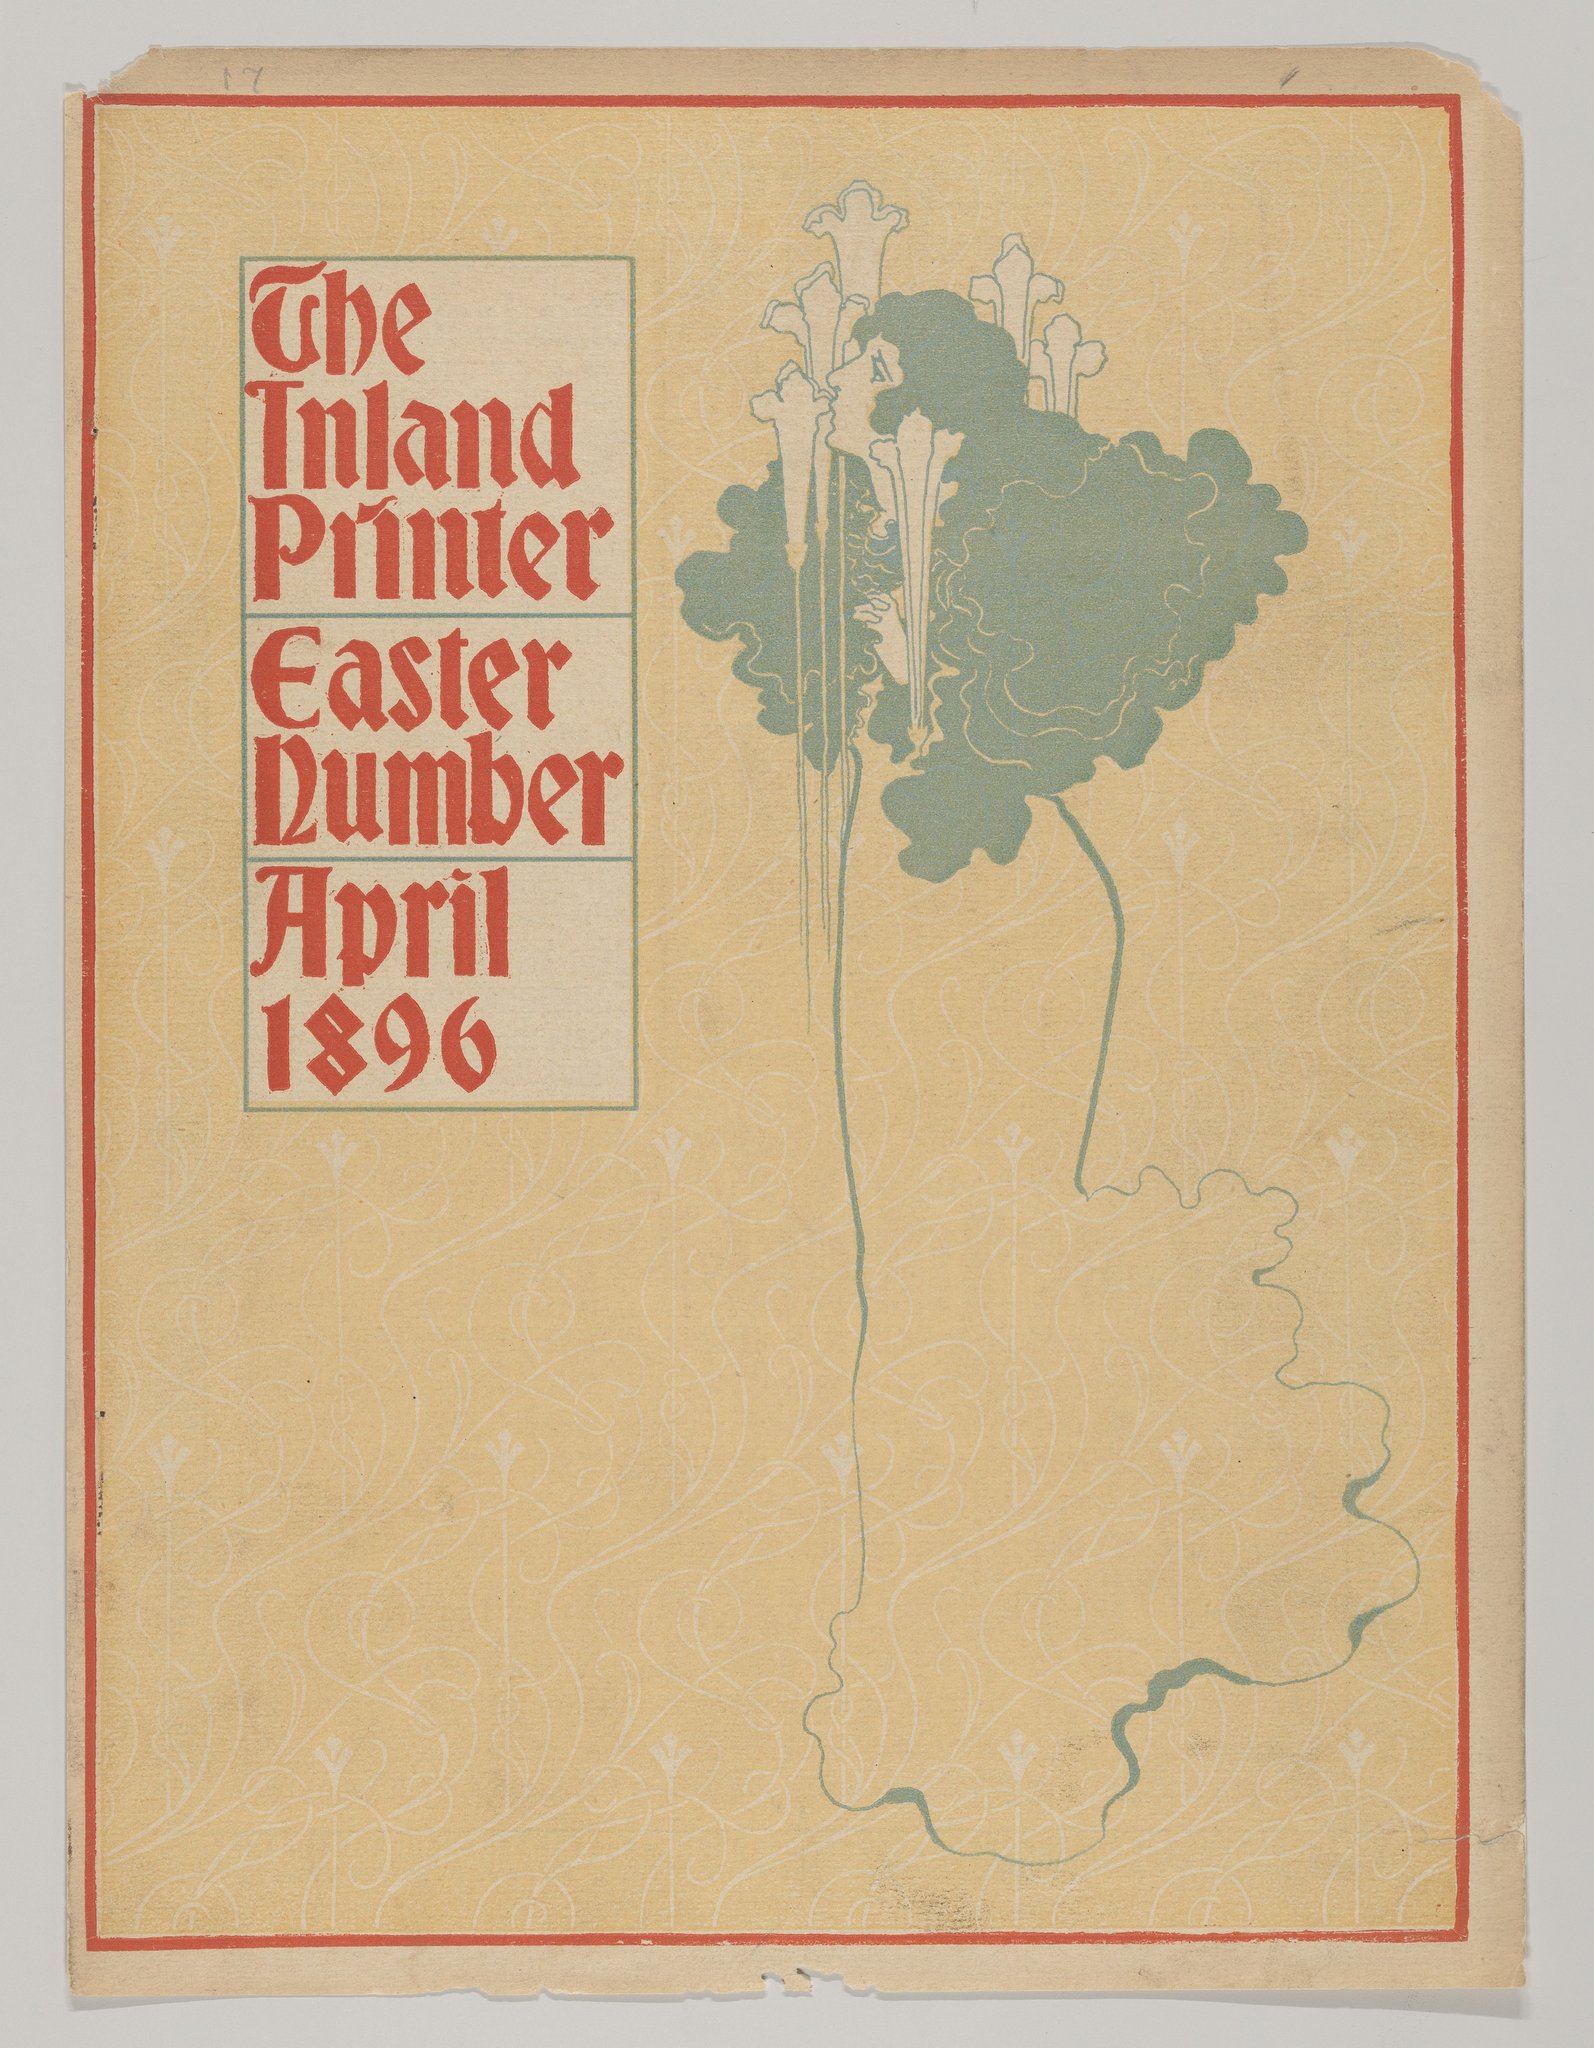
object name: print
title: Cover: The Inland Printer, The Easter Number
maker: anonymous, american, 19th century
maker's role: artist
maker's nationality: american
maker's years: 1800-1900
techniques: lithograph